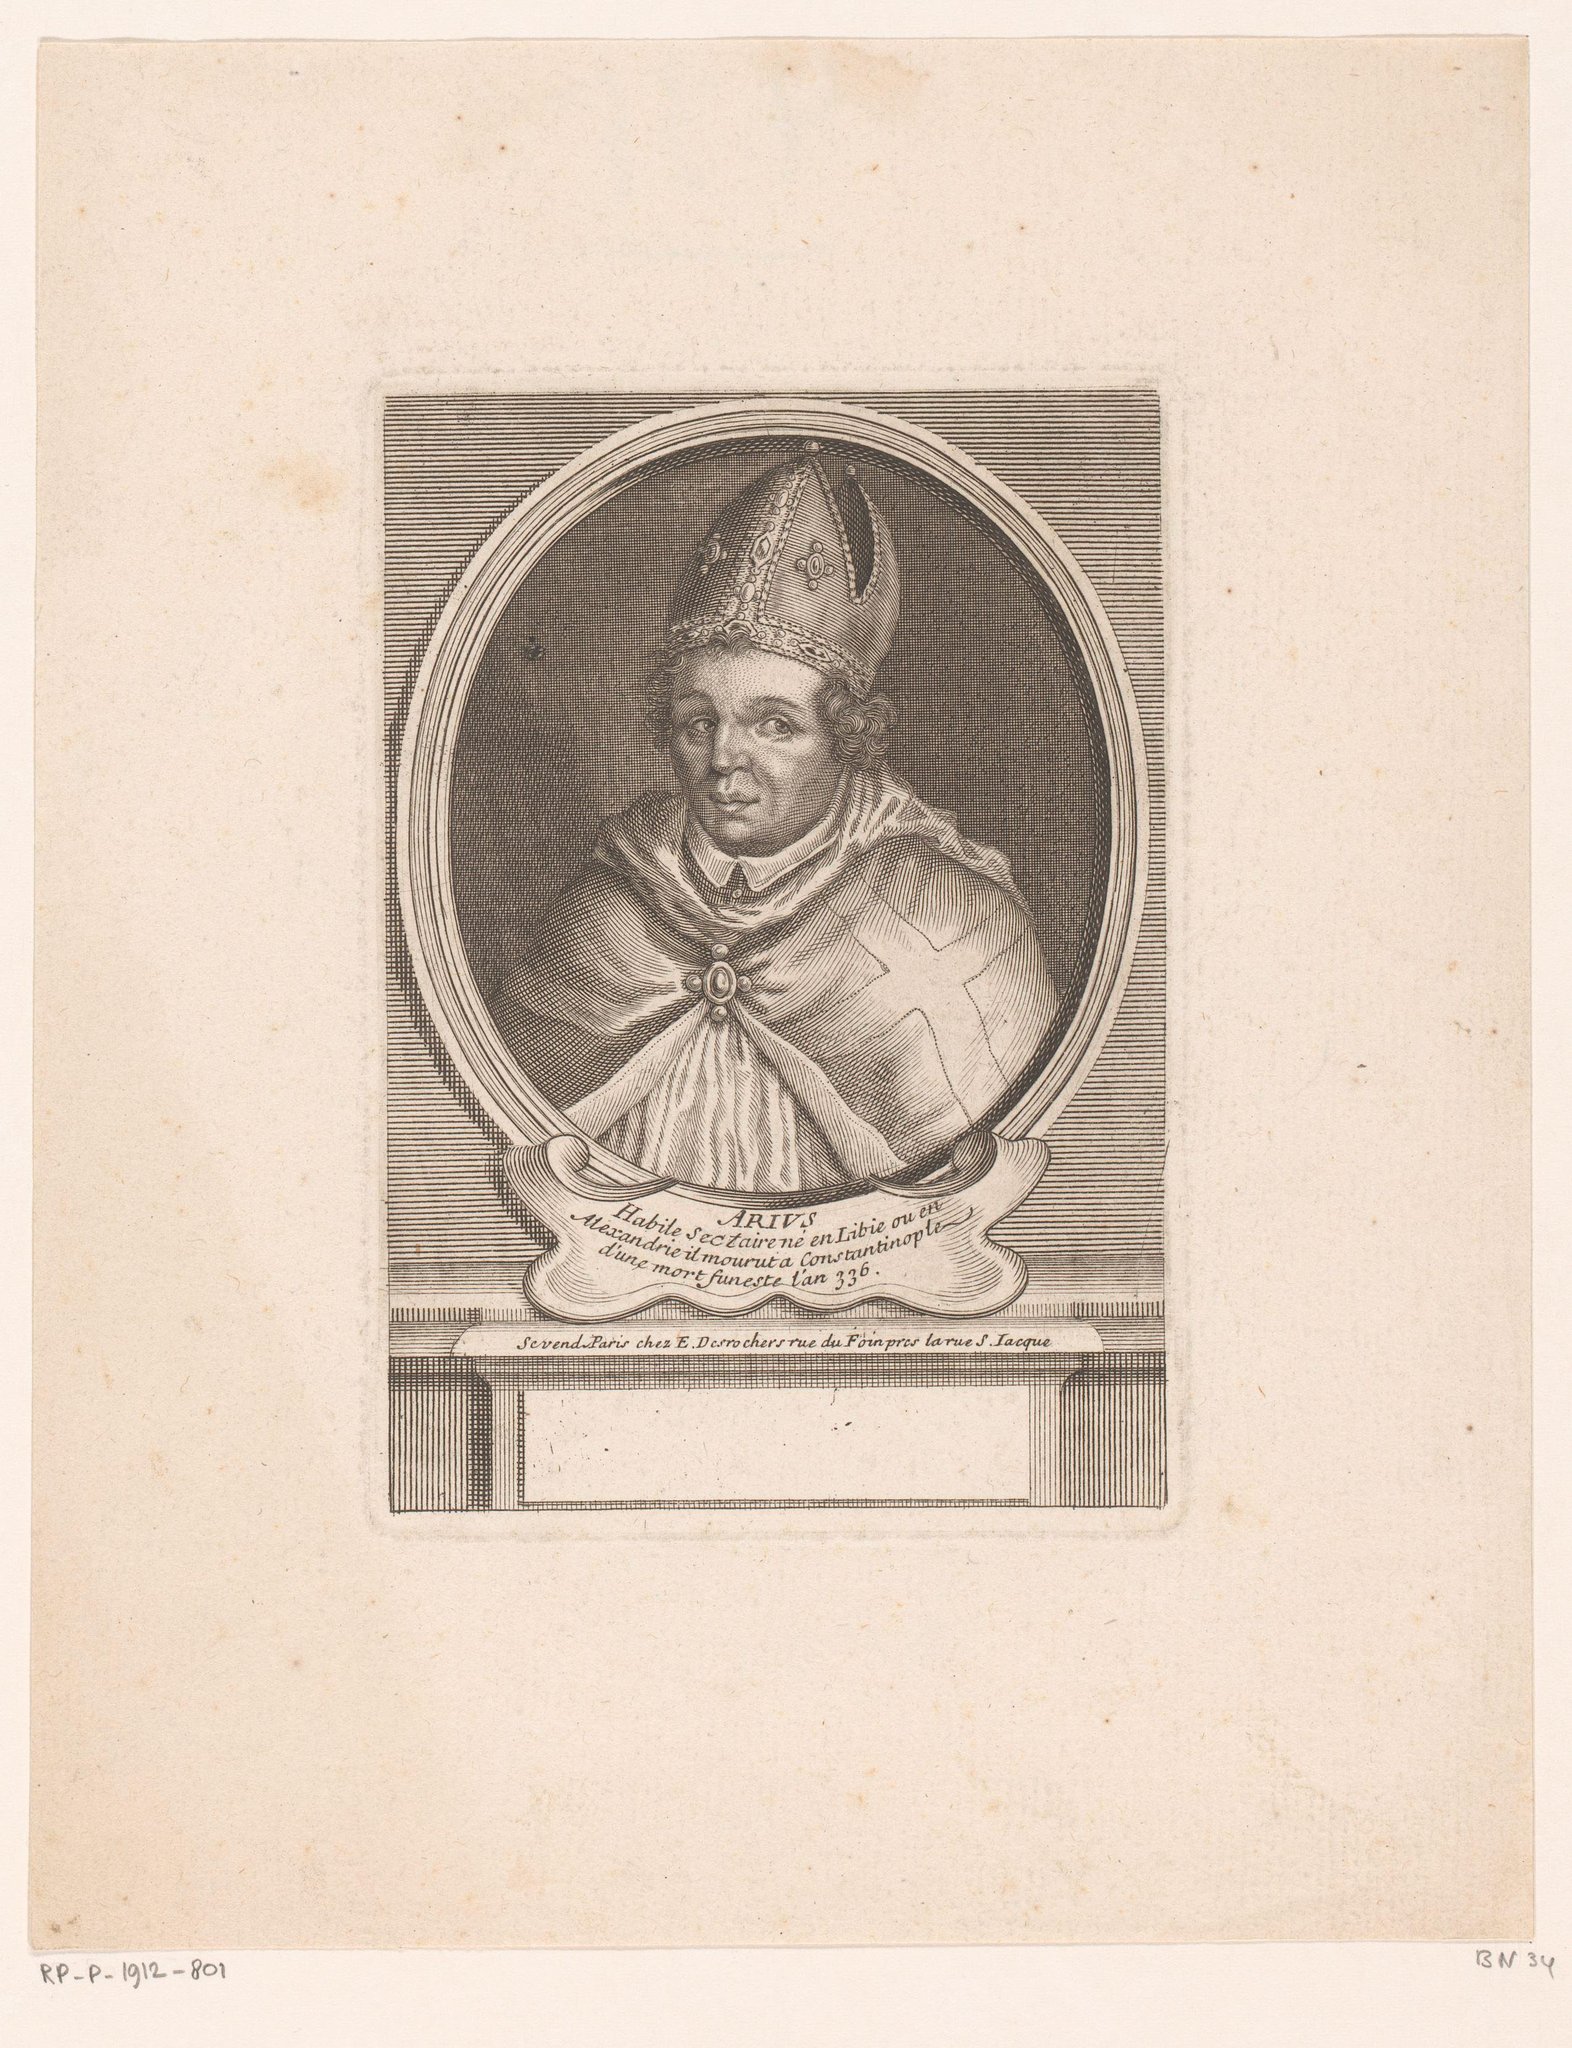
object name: print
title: Verzameling portretten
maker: étienne desrochers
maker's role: print maker, publisher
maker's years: 1668-1741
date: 1726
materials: paper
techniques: engraving, etching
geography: paris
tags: priest, theologian, historical persons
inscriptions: collector's mark: Lugt 2228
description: Behoort waarschijnlijk tot een serie portretten, grotendeels door Etienne Desrochers, getiteld: 'Recueil de portraits de personnes qui se sont distinguées tant dans les Armes que dans Belles-Lettres et les Arts, comme aussi la famille royale de France et autres cours étrangères'. De serie werd initieel uitgegeven door Desrochers en aangekondigd in 'Mercure' in mei 1726, p. 985. Echter was Desrochers reeds enkele jaren eerder begonnen met het uitgeven van de serie. Na de dood van Desrochers werd de serie voortgezet door Gilles Edme Petit. Een latere staat werd uitgegeven door Jean François Daumont in Parijs.